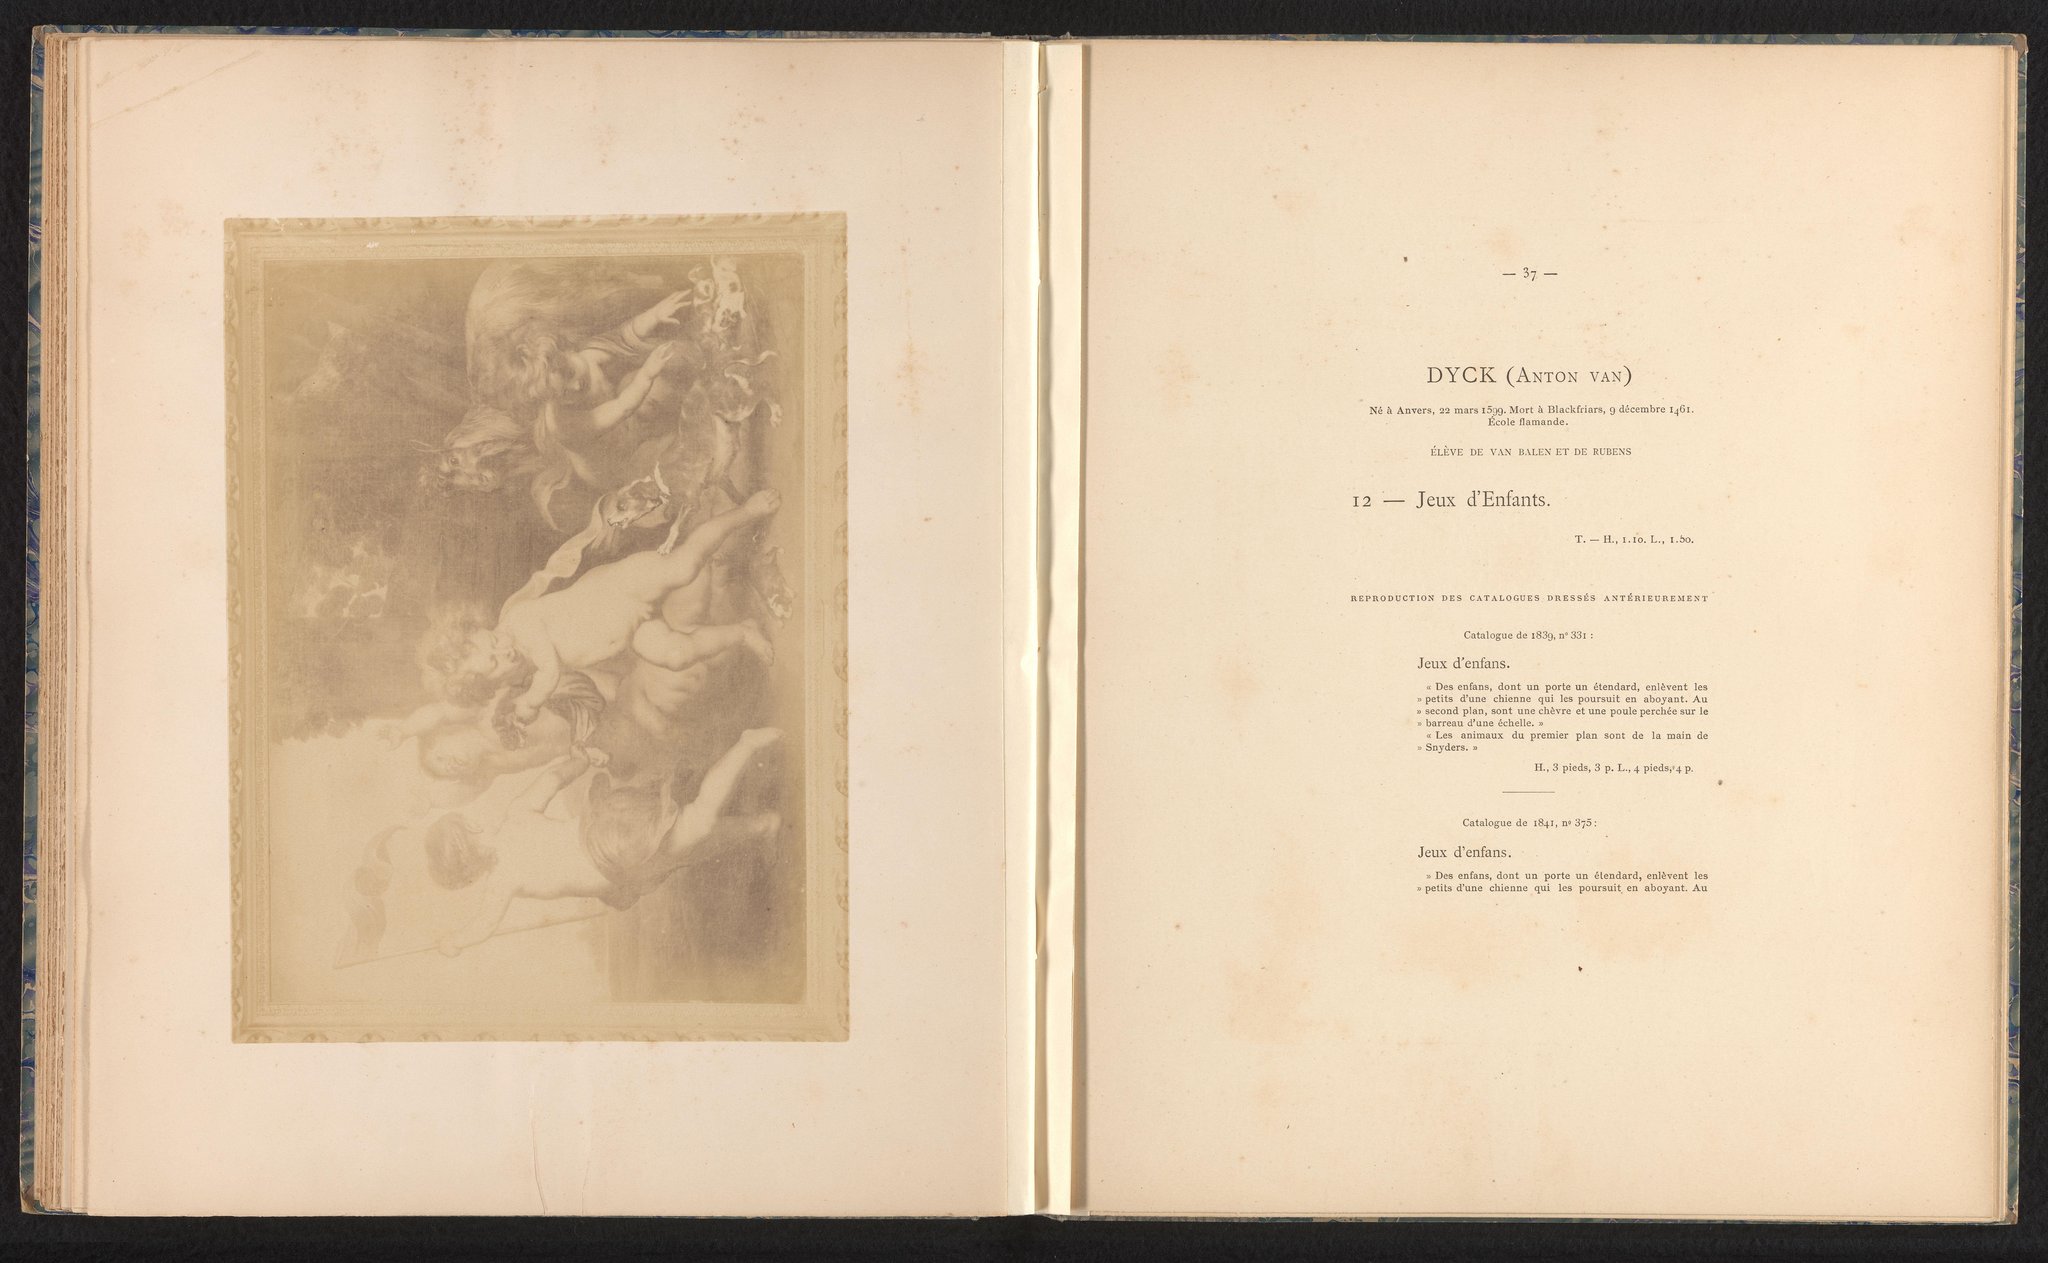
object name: reproduction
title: Fotoreproductie van een schilderij met spelende kinderen van Anthony van Dyck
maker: Anonymous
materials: paper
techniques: albumen print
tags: child, dog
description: Foto op de 56e ongenummerde pagina na titelpagina.